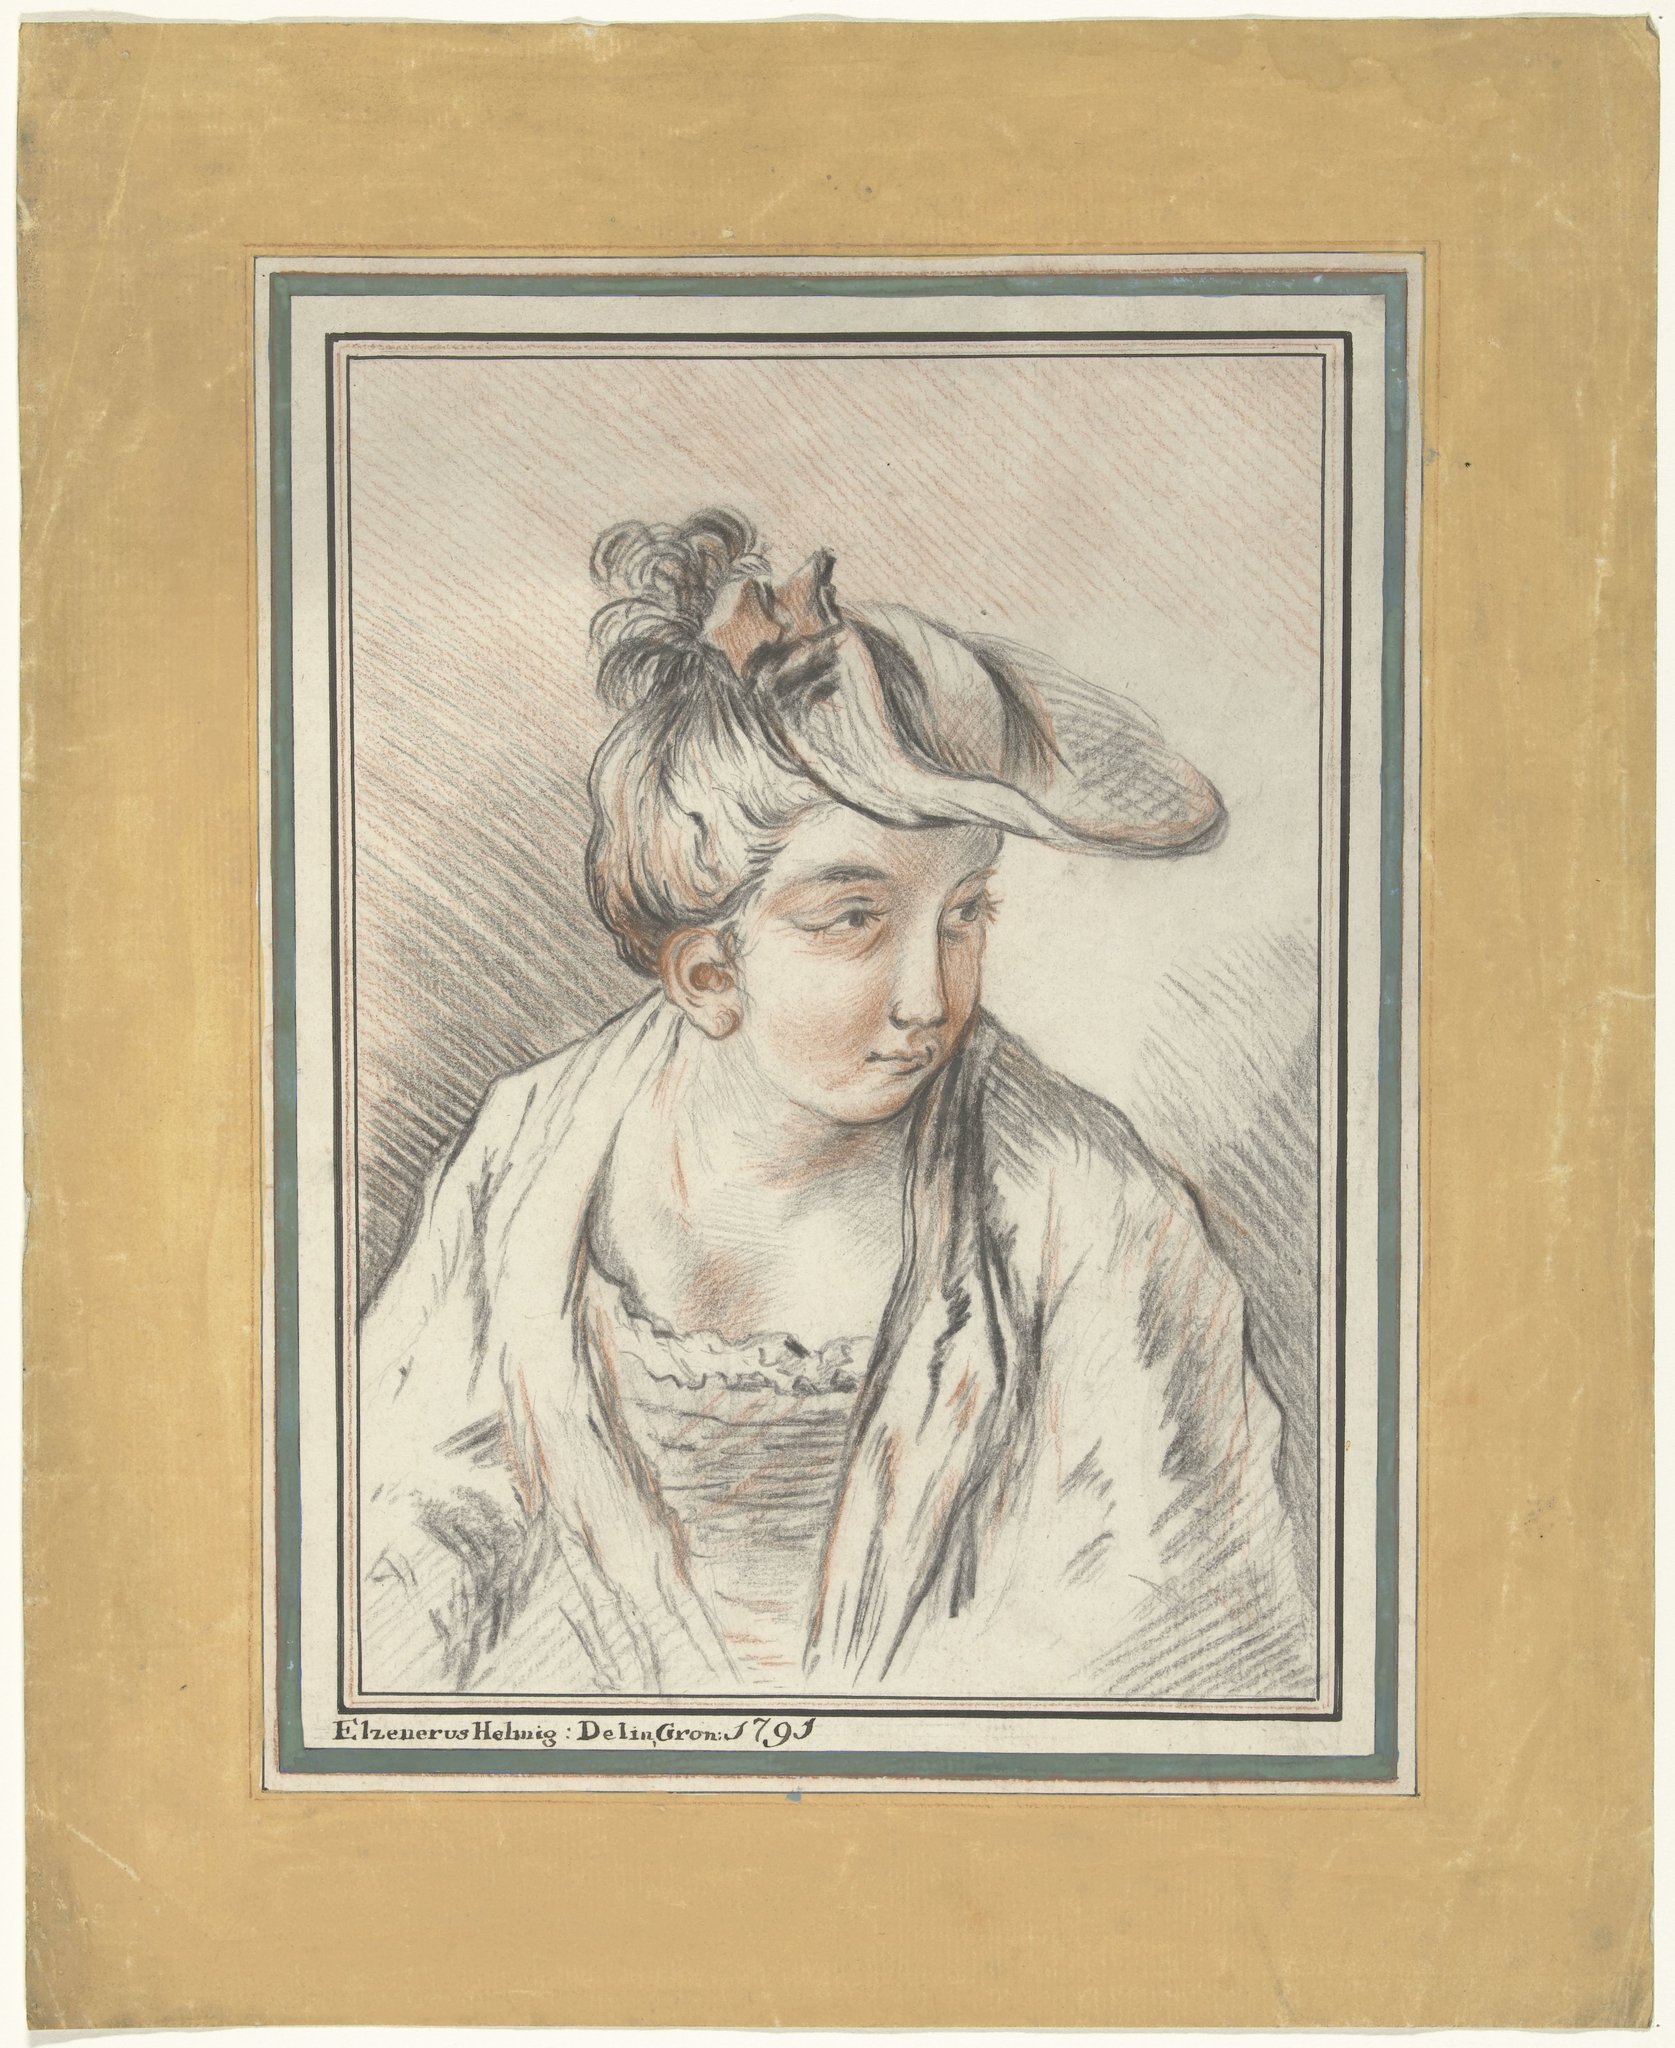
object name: drawing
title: Vrouwenkop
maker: elzenerus helmigh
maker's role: draughtsman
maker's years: 1776-1822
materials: chalk, paper, watercolor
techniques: brush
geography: groningen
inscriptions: inscription: ‘Deze kop is zonder eenige hulp getekend, door Elzenerus Helmig stom en doof, / geb. te Goor in Twente, onder het oog van zynen onderwijzer / Groningen den 1 maart 1791 / Wibrand Veltman’